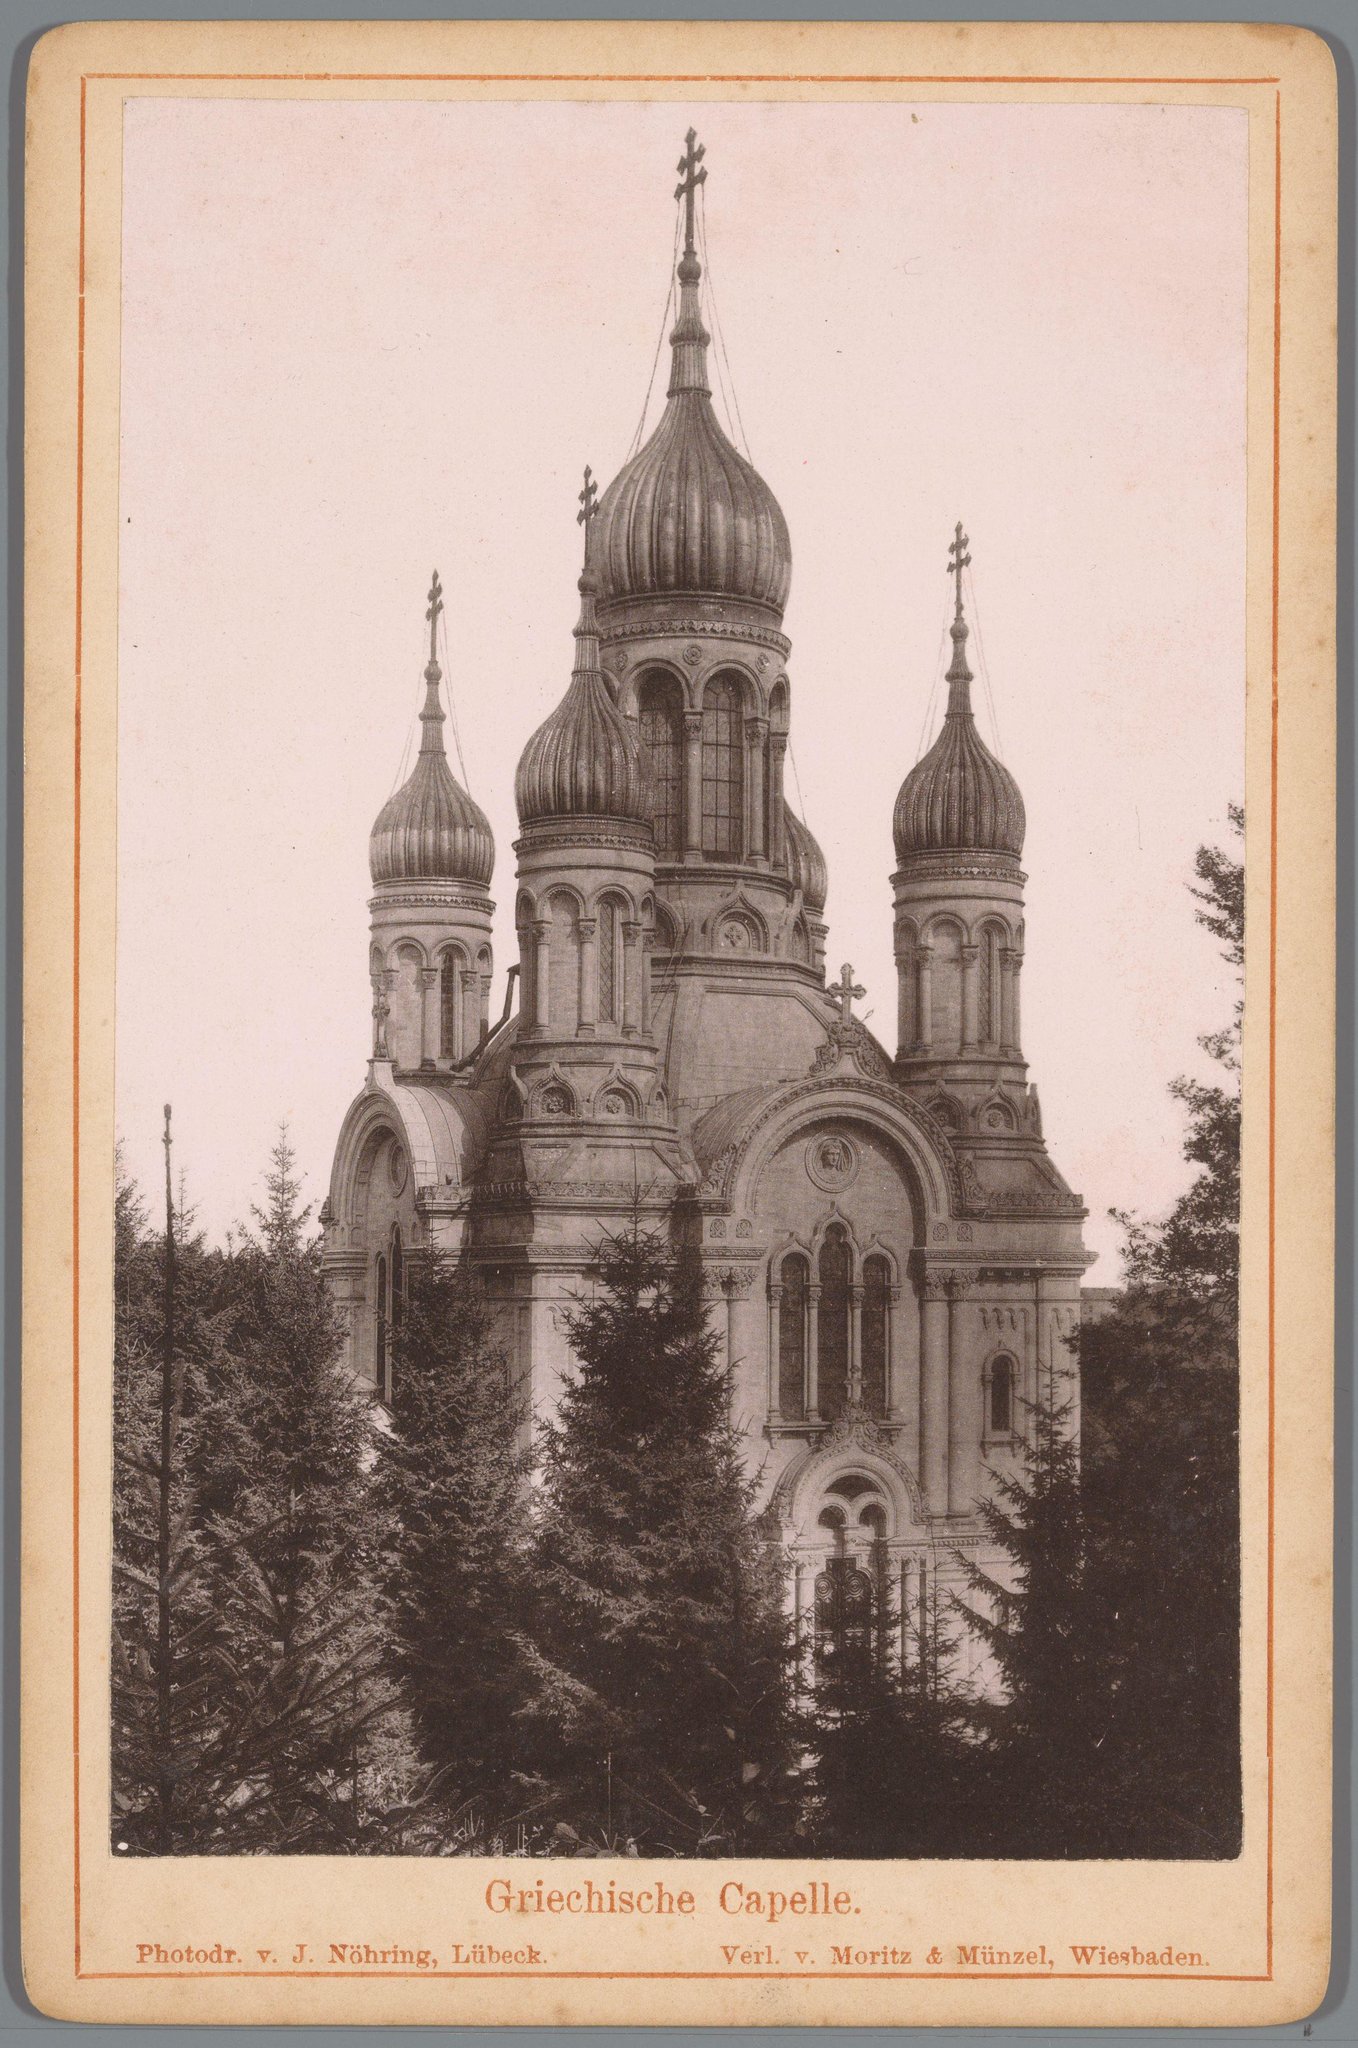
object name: photomechanical print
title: Griechische Capelle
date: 1869-1900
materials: cardboard, paper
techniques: photograph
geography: wiesbaden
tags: parts of church exterior and annexes: chapel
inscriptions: name: ‘Vosmaer’